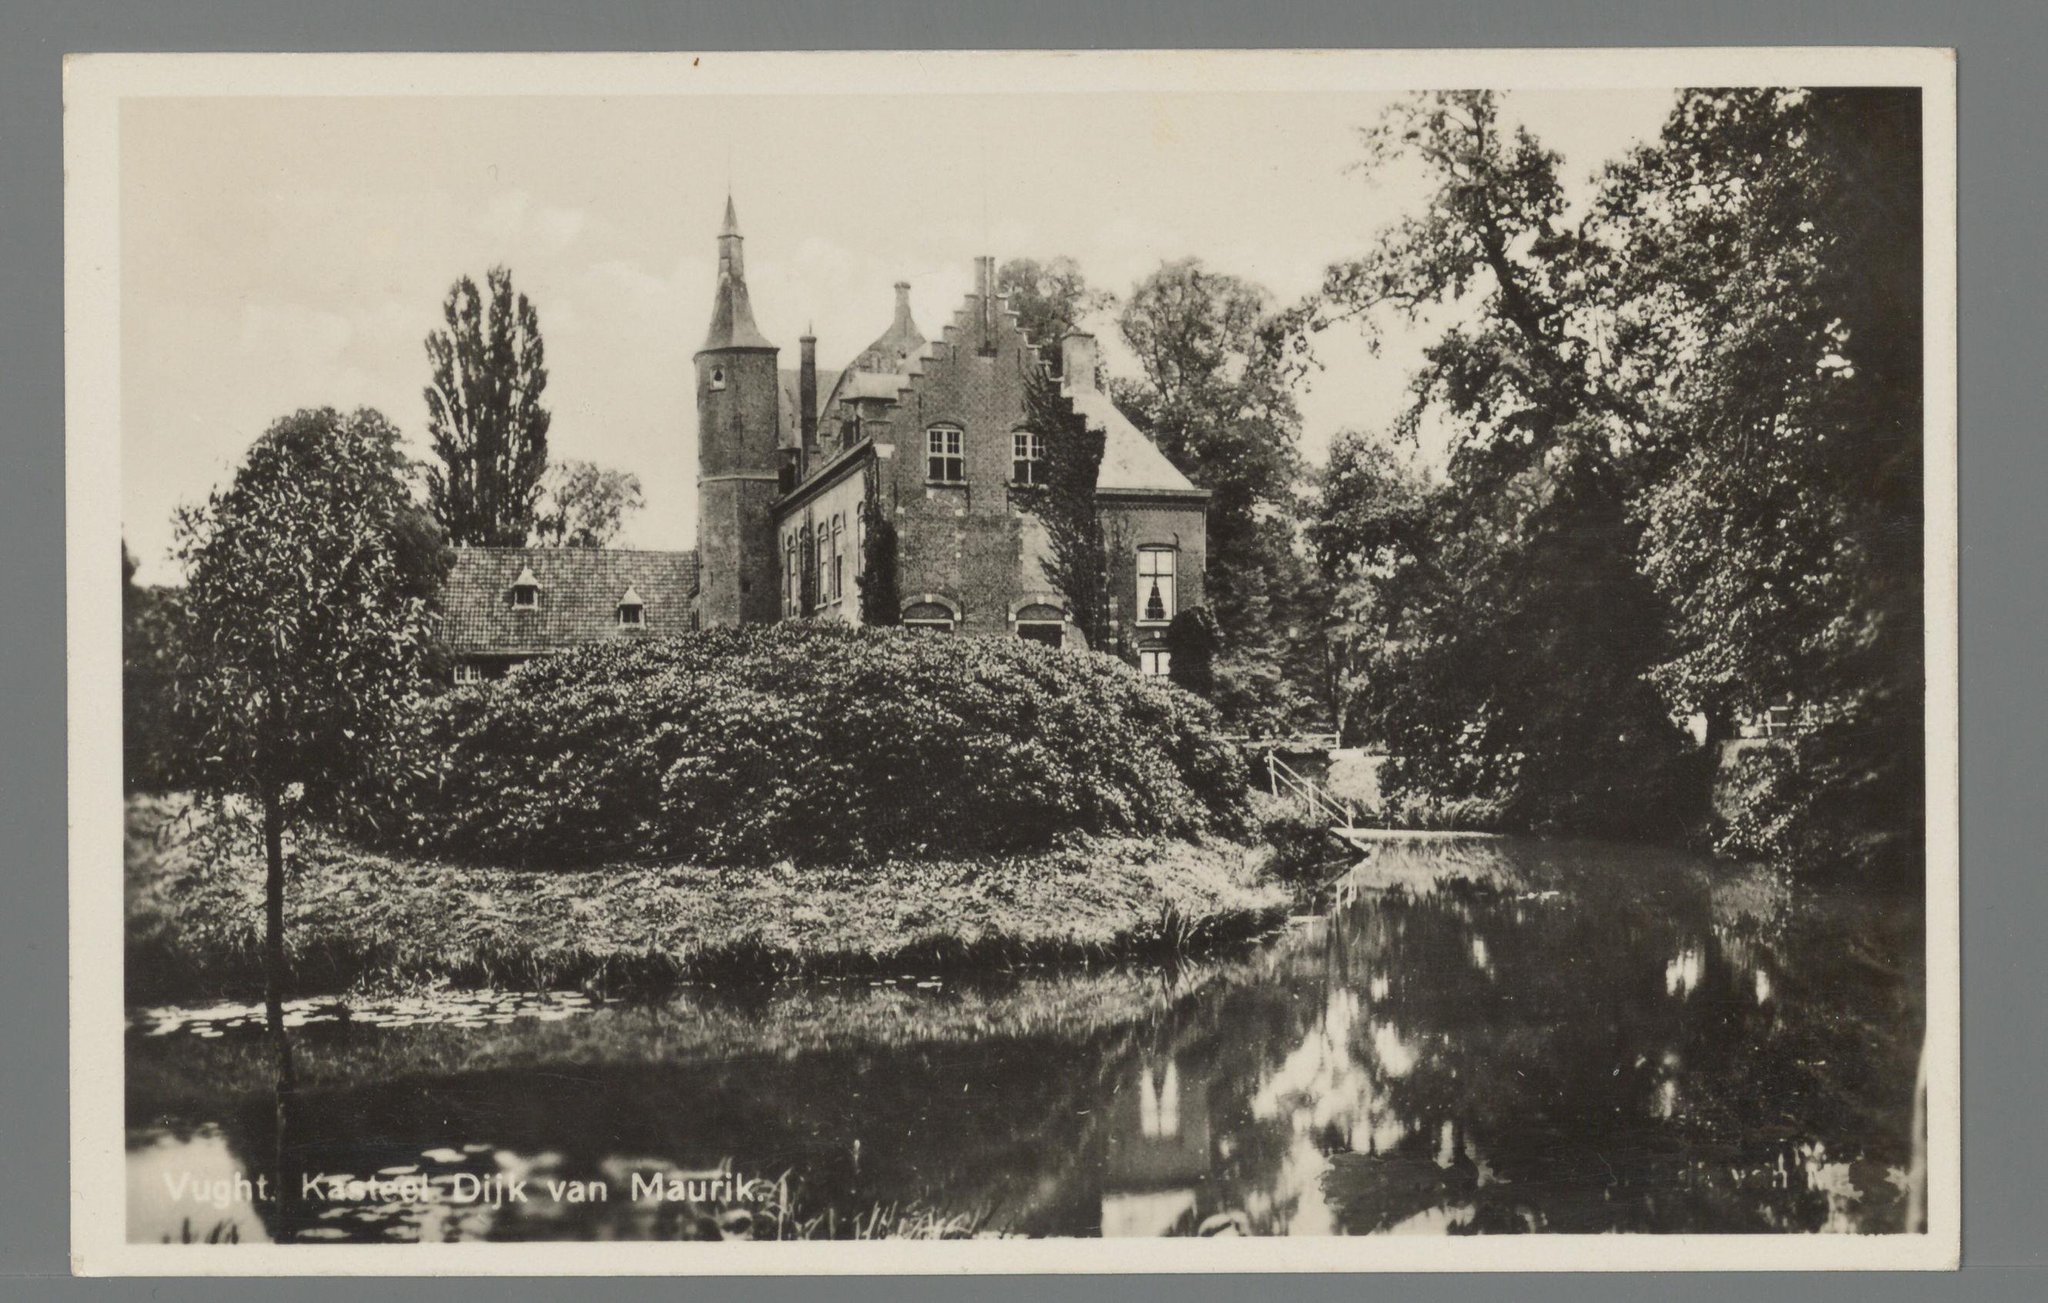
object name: ansichtkaart, prentbriefkaart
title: Vught. Kasteel Dijk van Maurik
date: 1929-1936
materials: paper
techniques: gelatin silver print, writing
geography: vught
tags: castle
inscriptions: postage stamp